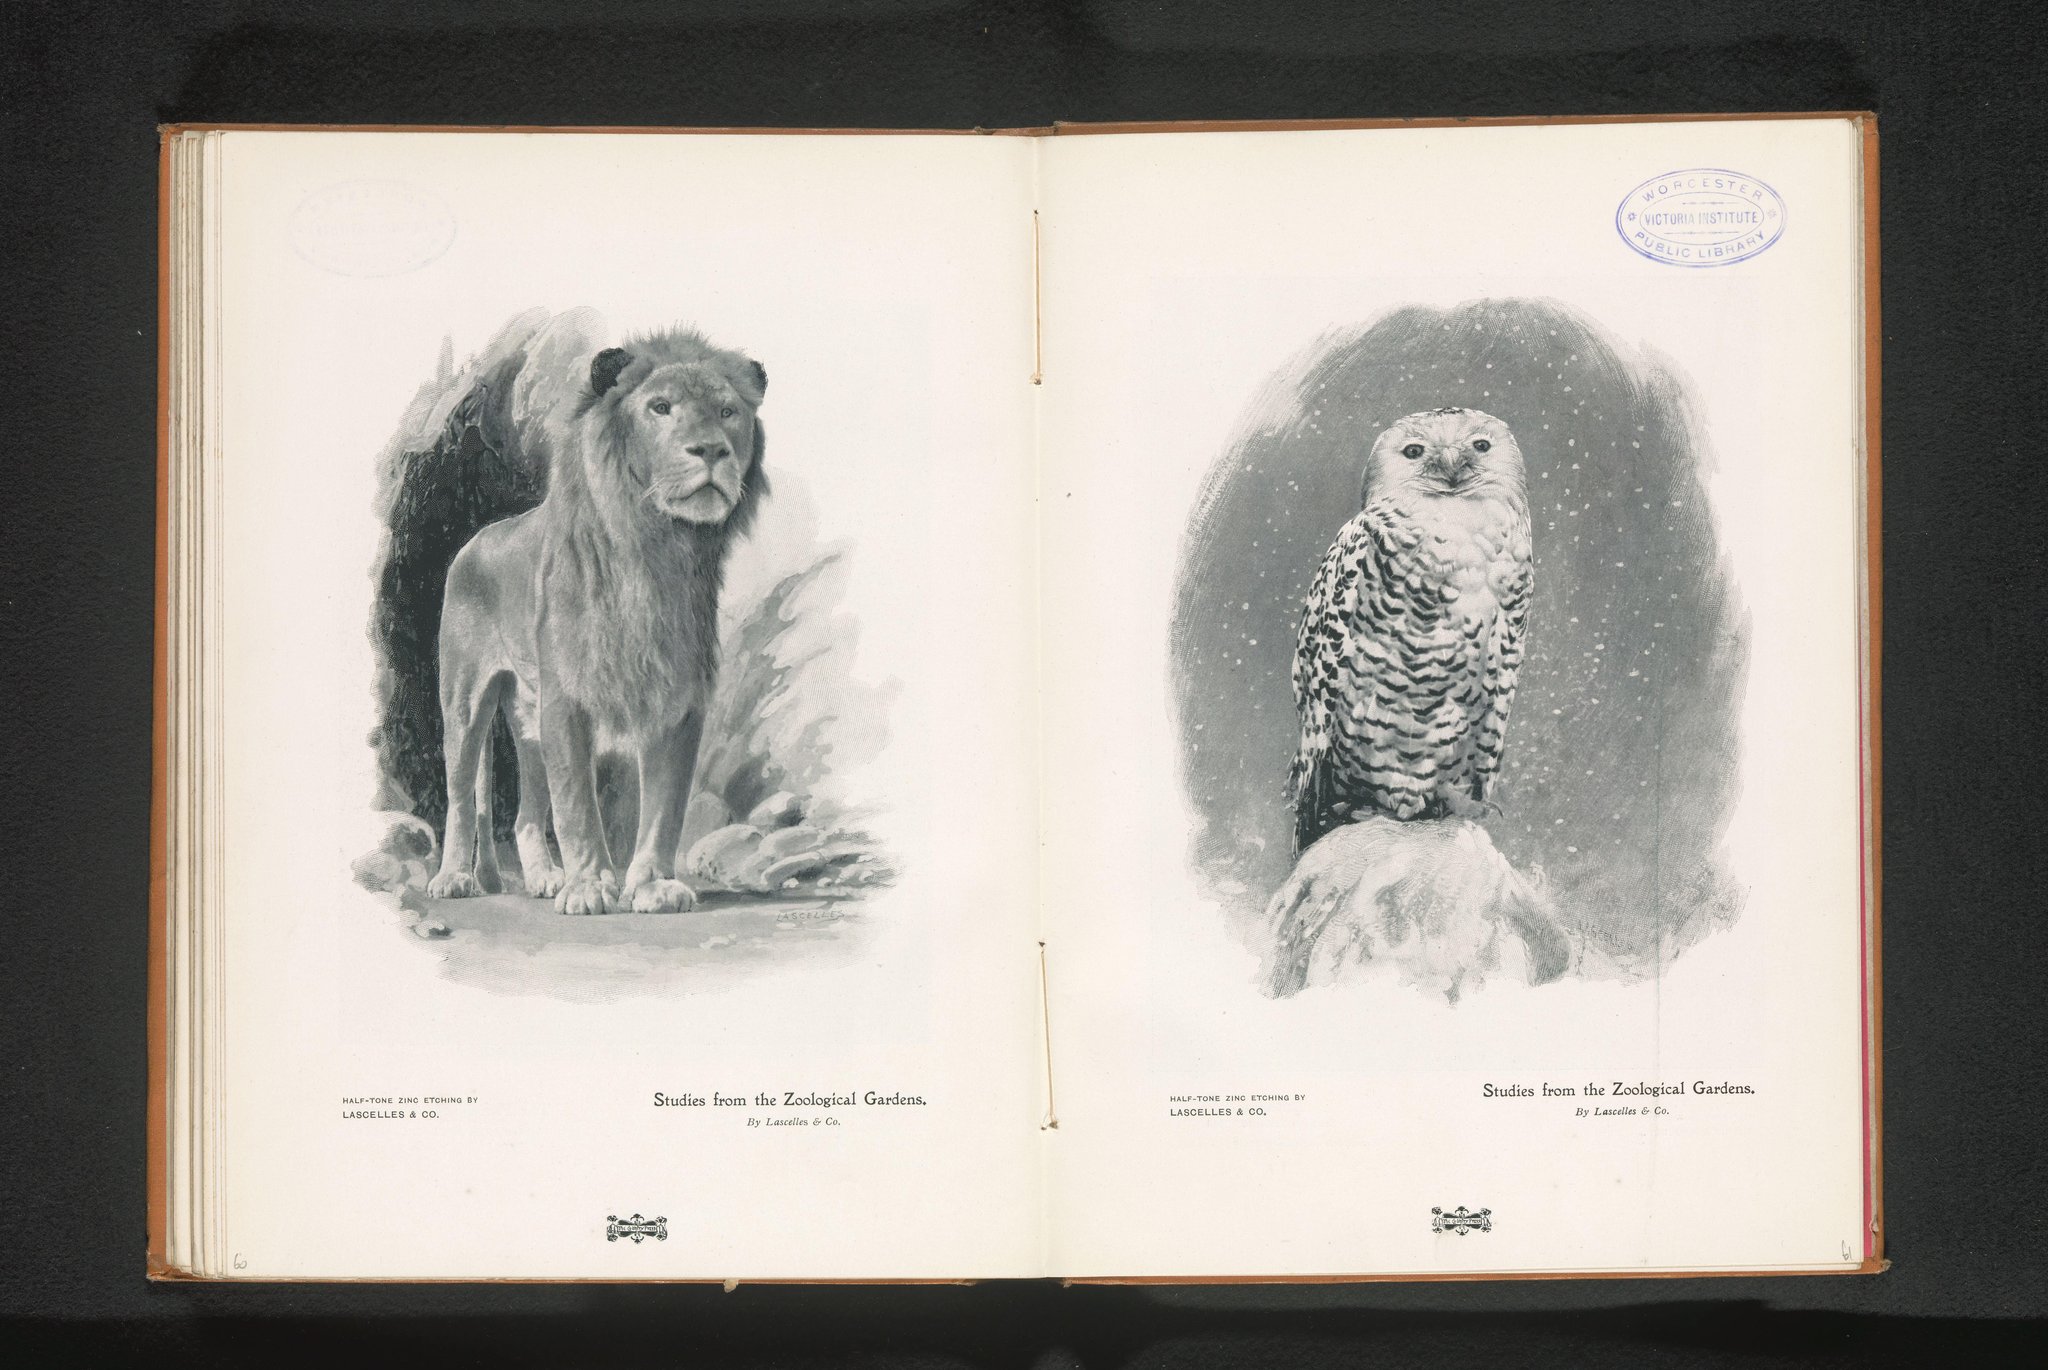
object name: page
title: Studies from the zoological gardens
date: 1894-1899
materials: paper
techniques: autotype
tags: beasts of prey, predatory animals: lion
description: Prent op vierde ongenummerde pagina na pagina 84.